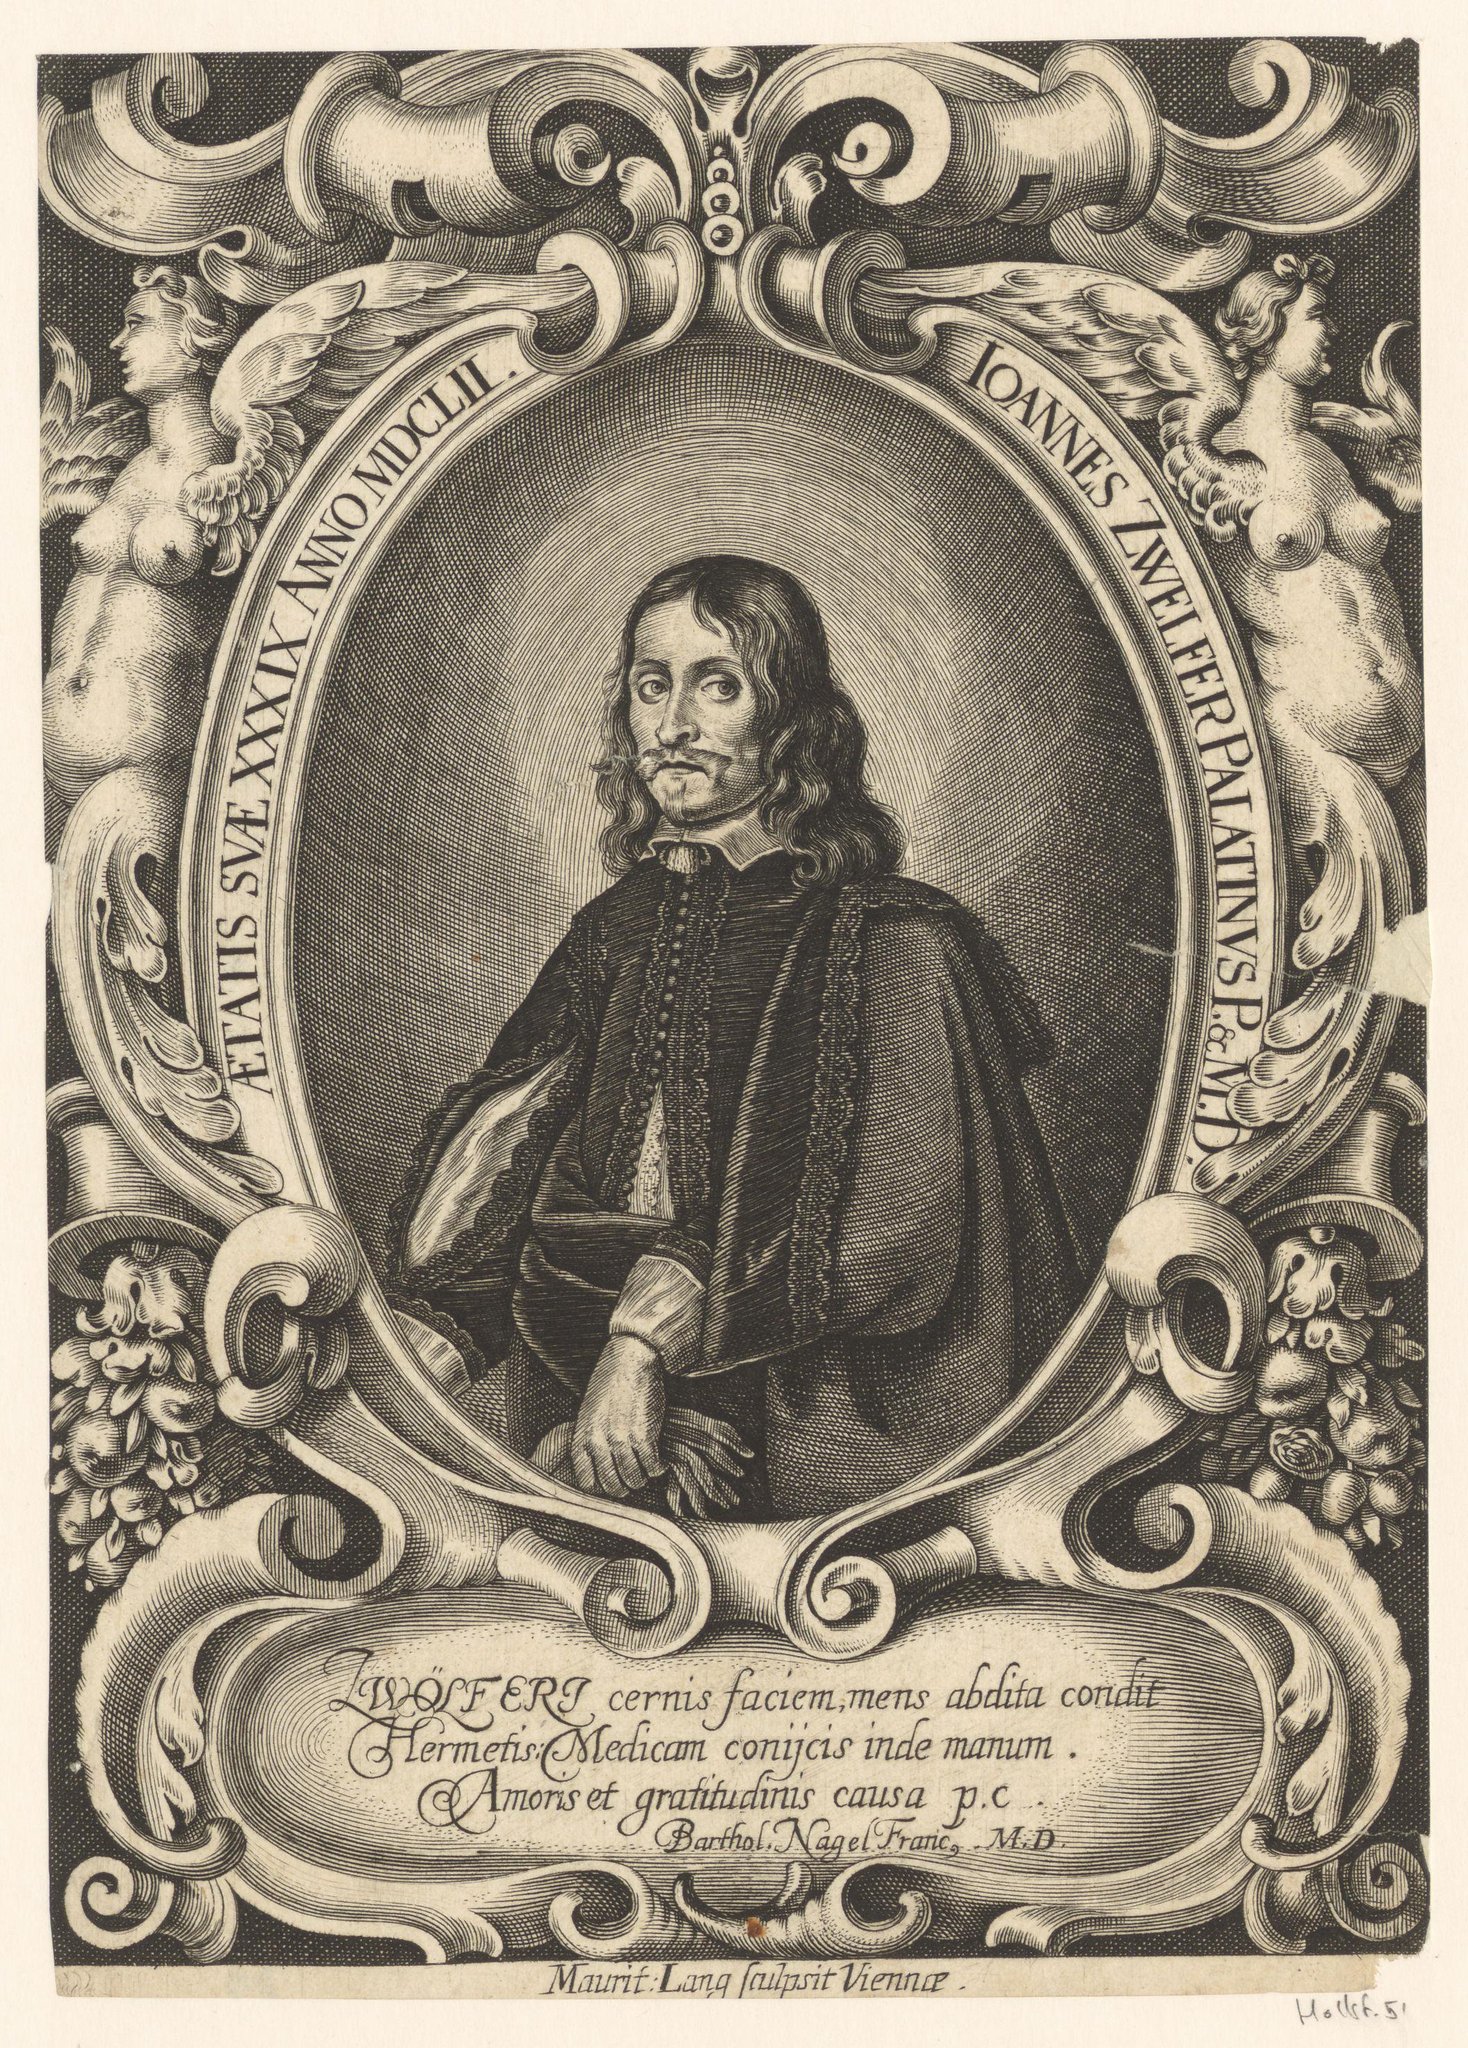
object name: print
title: Portret van Johann Zwelfer op 39-jarige leeftijd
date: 1652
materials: paper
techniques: engraving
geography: vienna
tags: vienna, historical persons, physician, doctor (+ portrait of scholar, scientist)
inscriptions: collector's mark: Lugt 2228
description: Tekst in het Latijn in de omlijsting en in de cartouche.